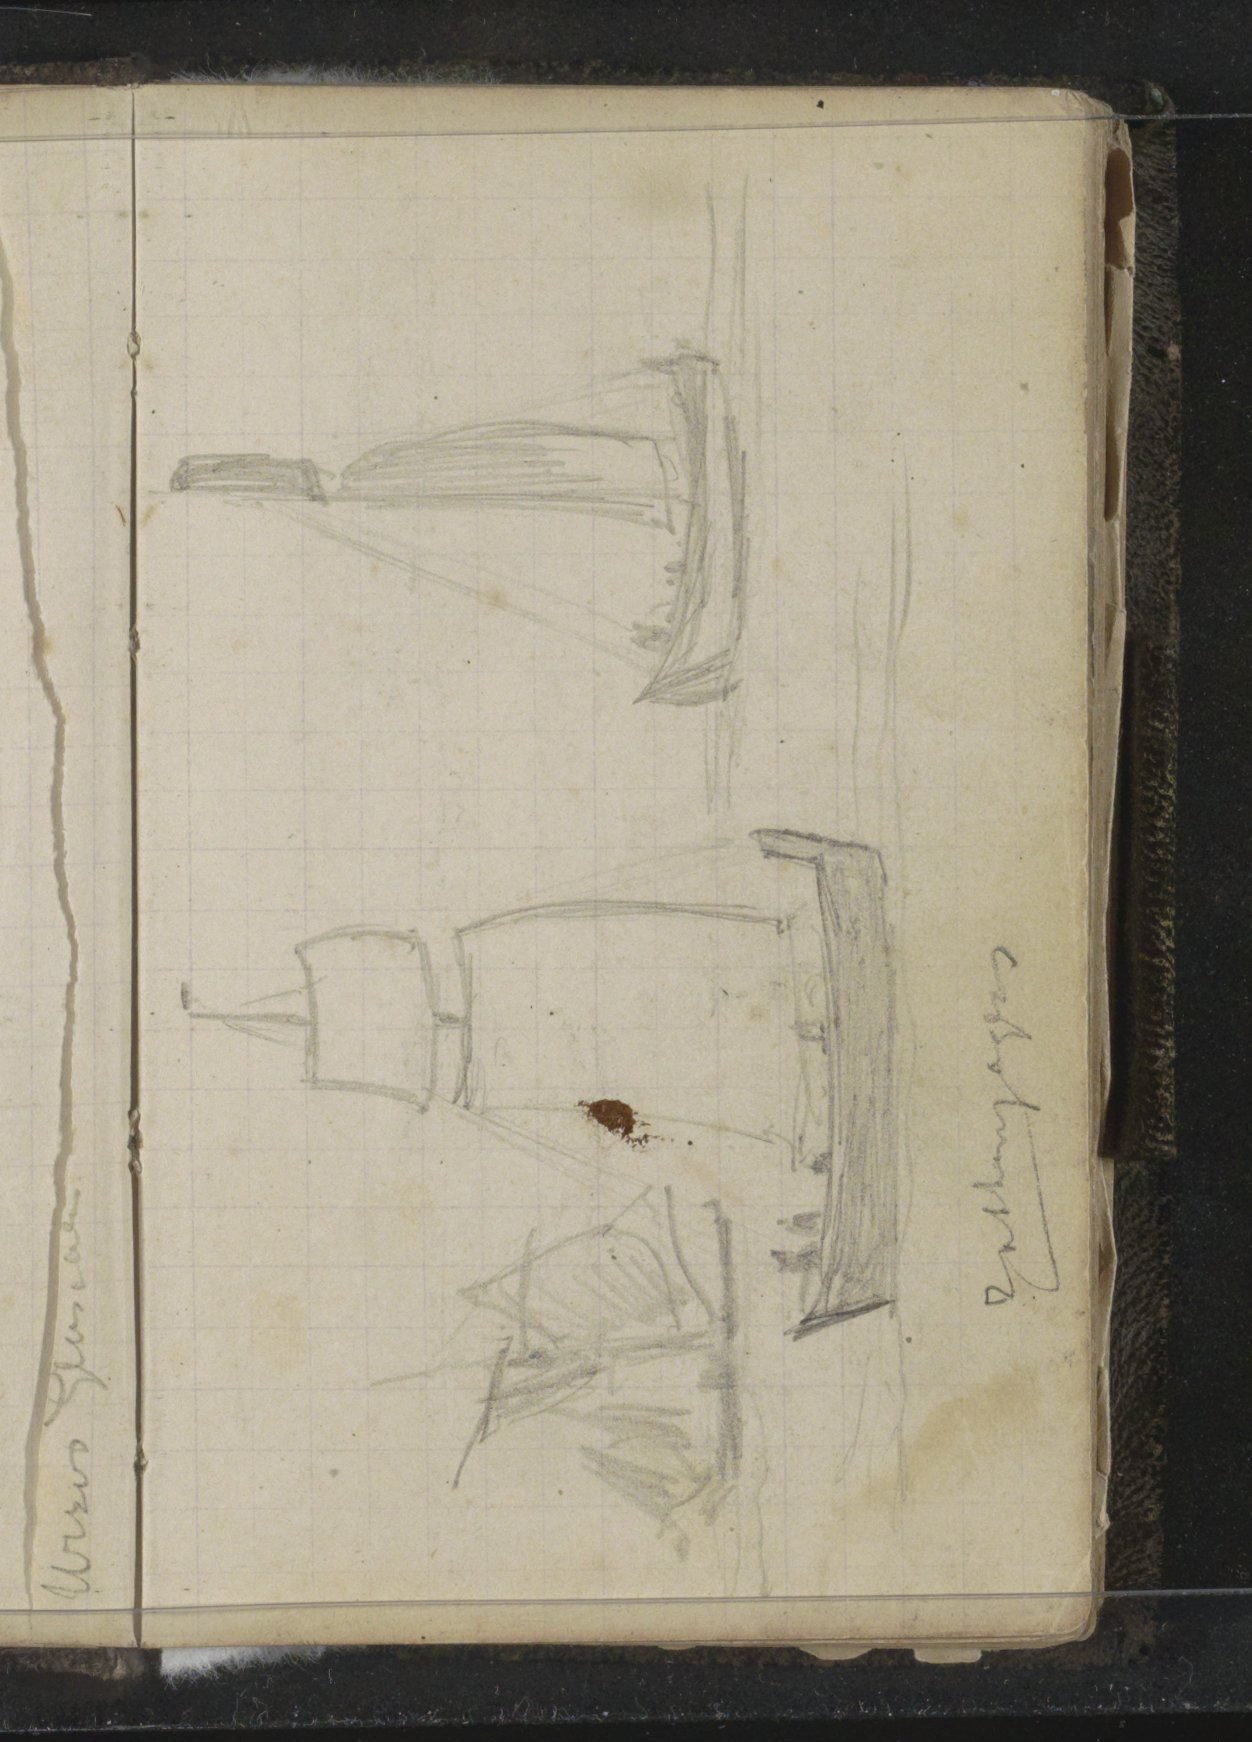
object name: sketchbook leaf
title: Robbenjagers op zee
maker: louis apol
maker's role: draughtsman, painter, print maker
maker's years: 1850-1936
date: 1807-1880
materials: pencil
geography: barentsz sea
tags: sailing-ship, sailing-boat, sea (seascape)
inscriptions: annotation: ‘robbenjagers’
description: Blad 10 recto uit een schetsboek met 110 bladen betekend tijdens de expeditie naar Nova Zembla in 1880.